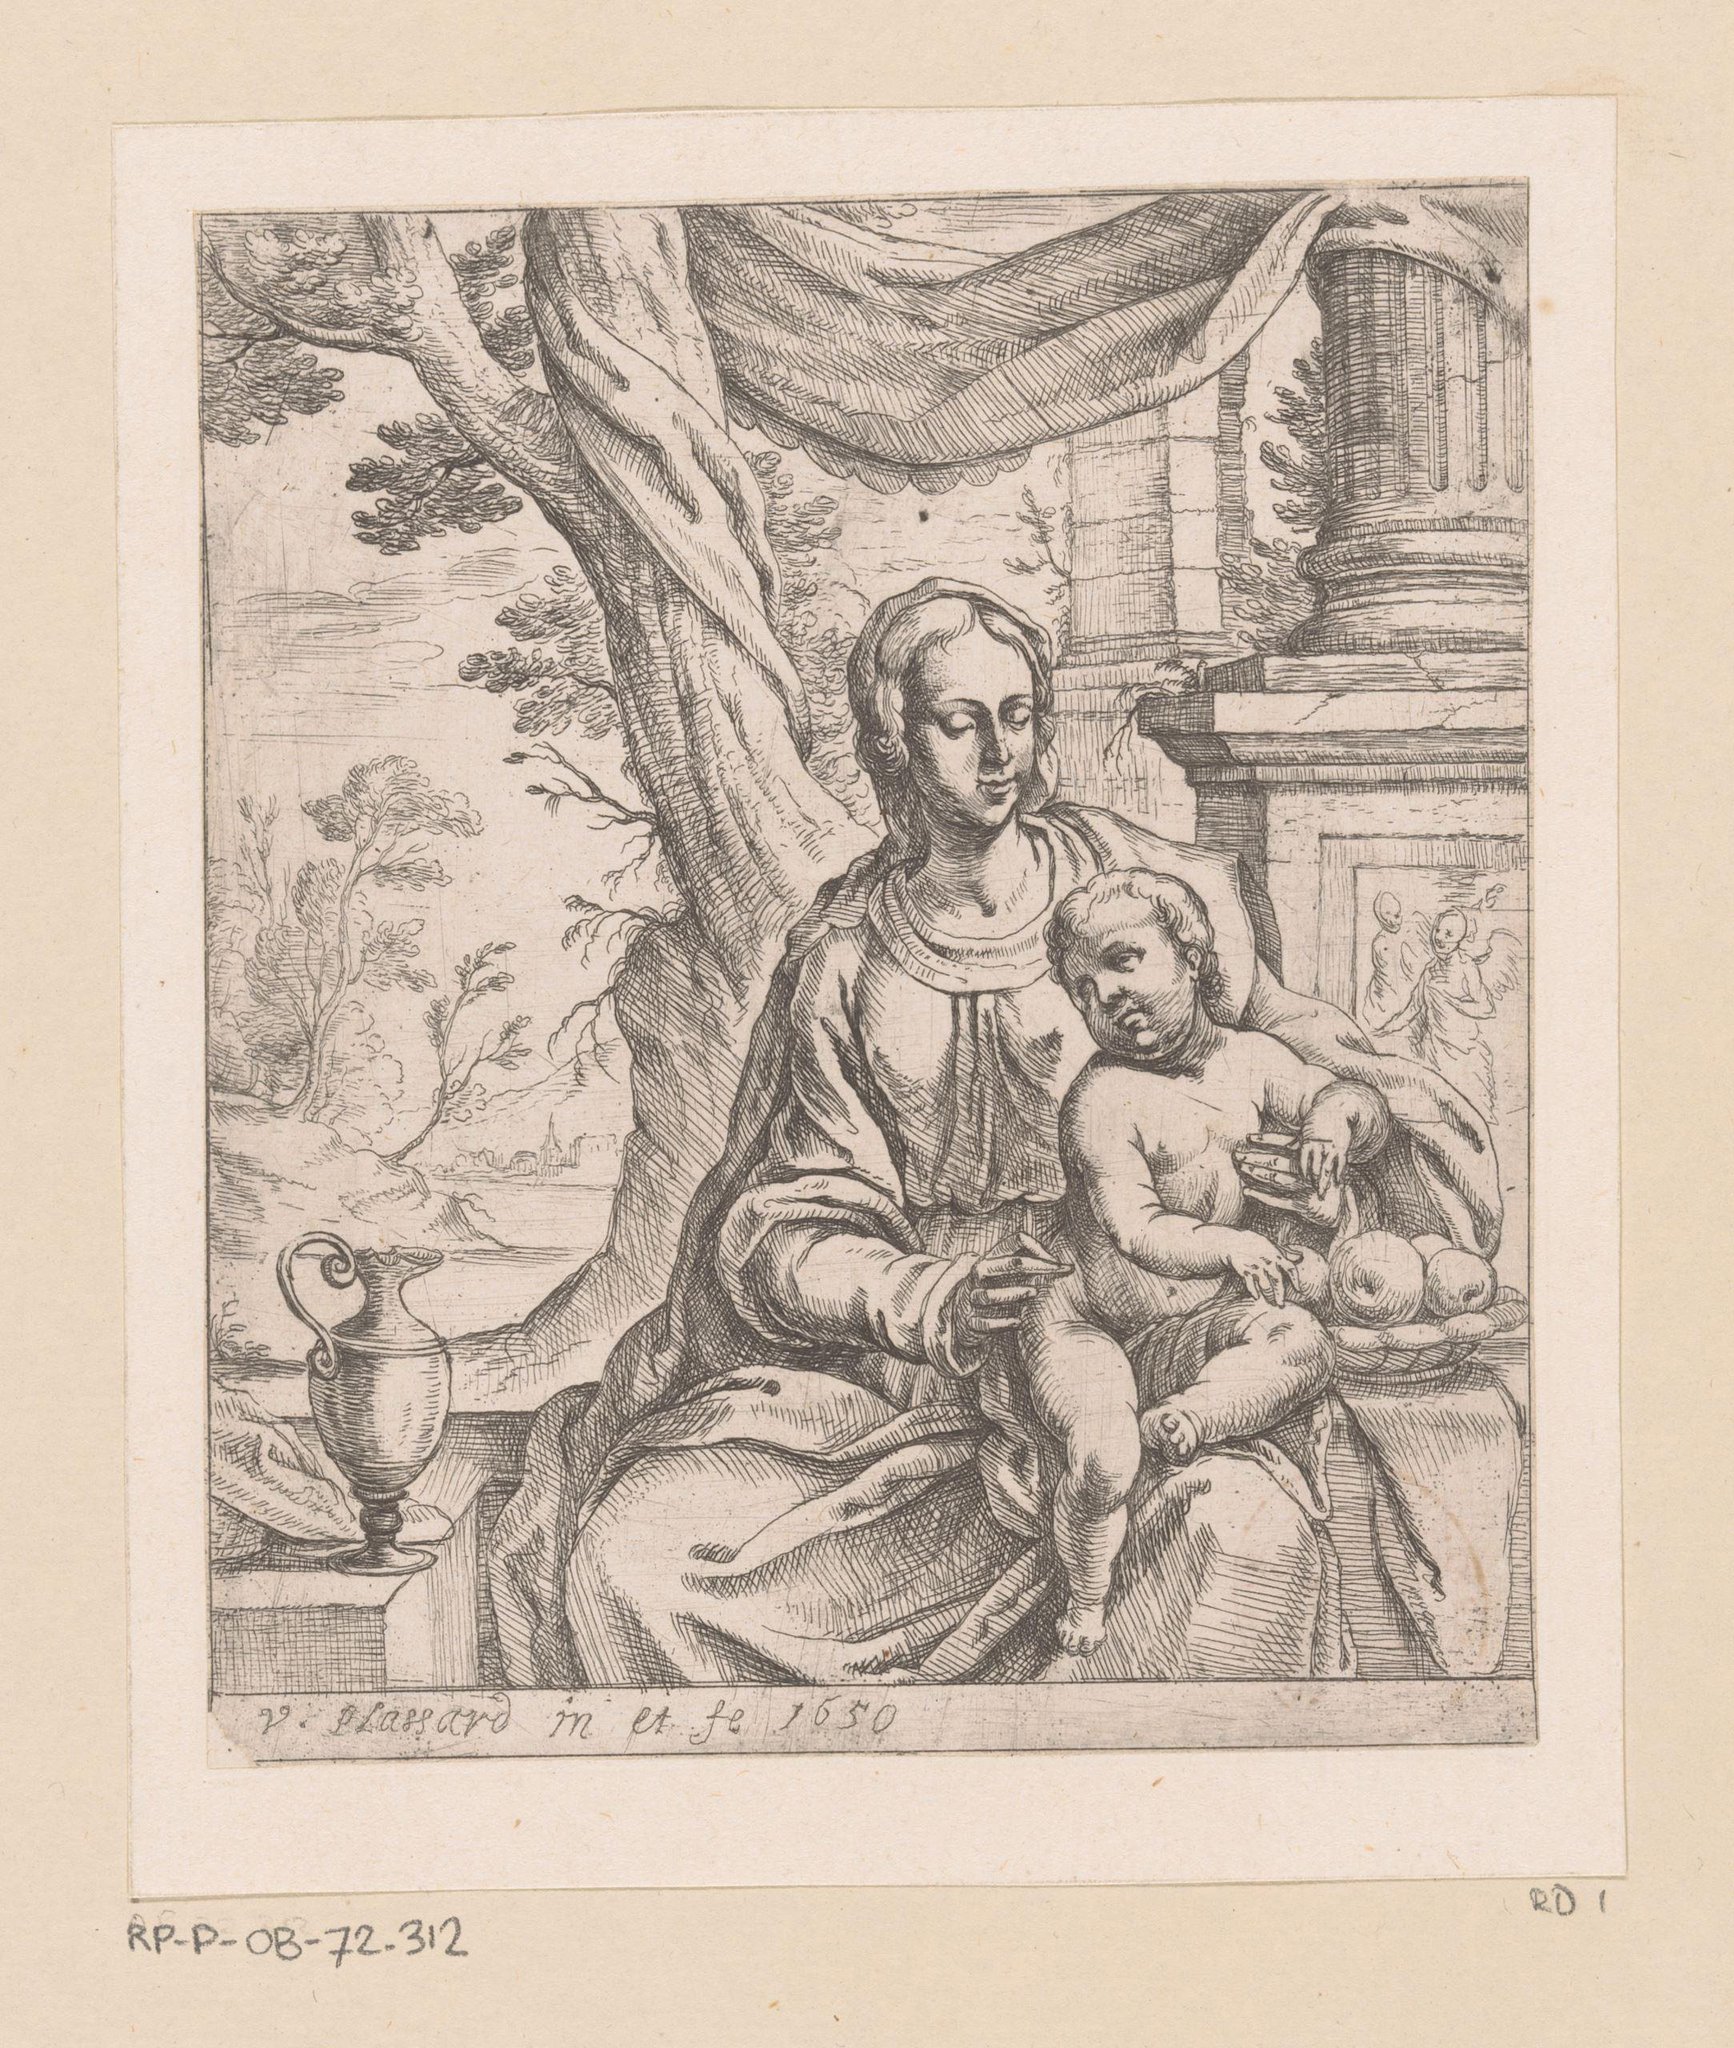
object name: print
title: Maria met kind en schaal met fruit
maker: vincent plassard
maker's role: print maker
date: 1650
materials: paper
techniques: etching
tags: madonna: i.e. mary with the christ-child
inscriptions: collector's mark: Lugt 240